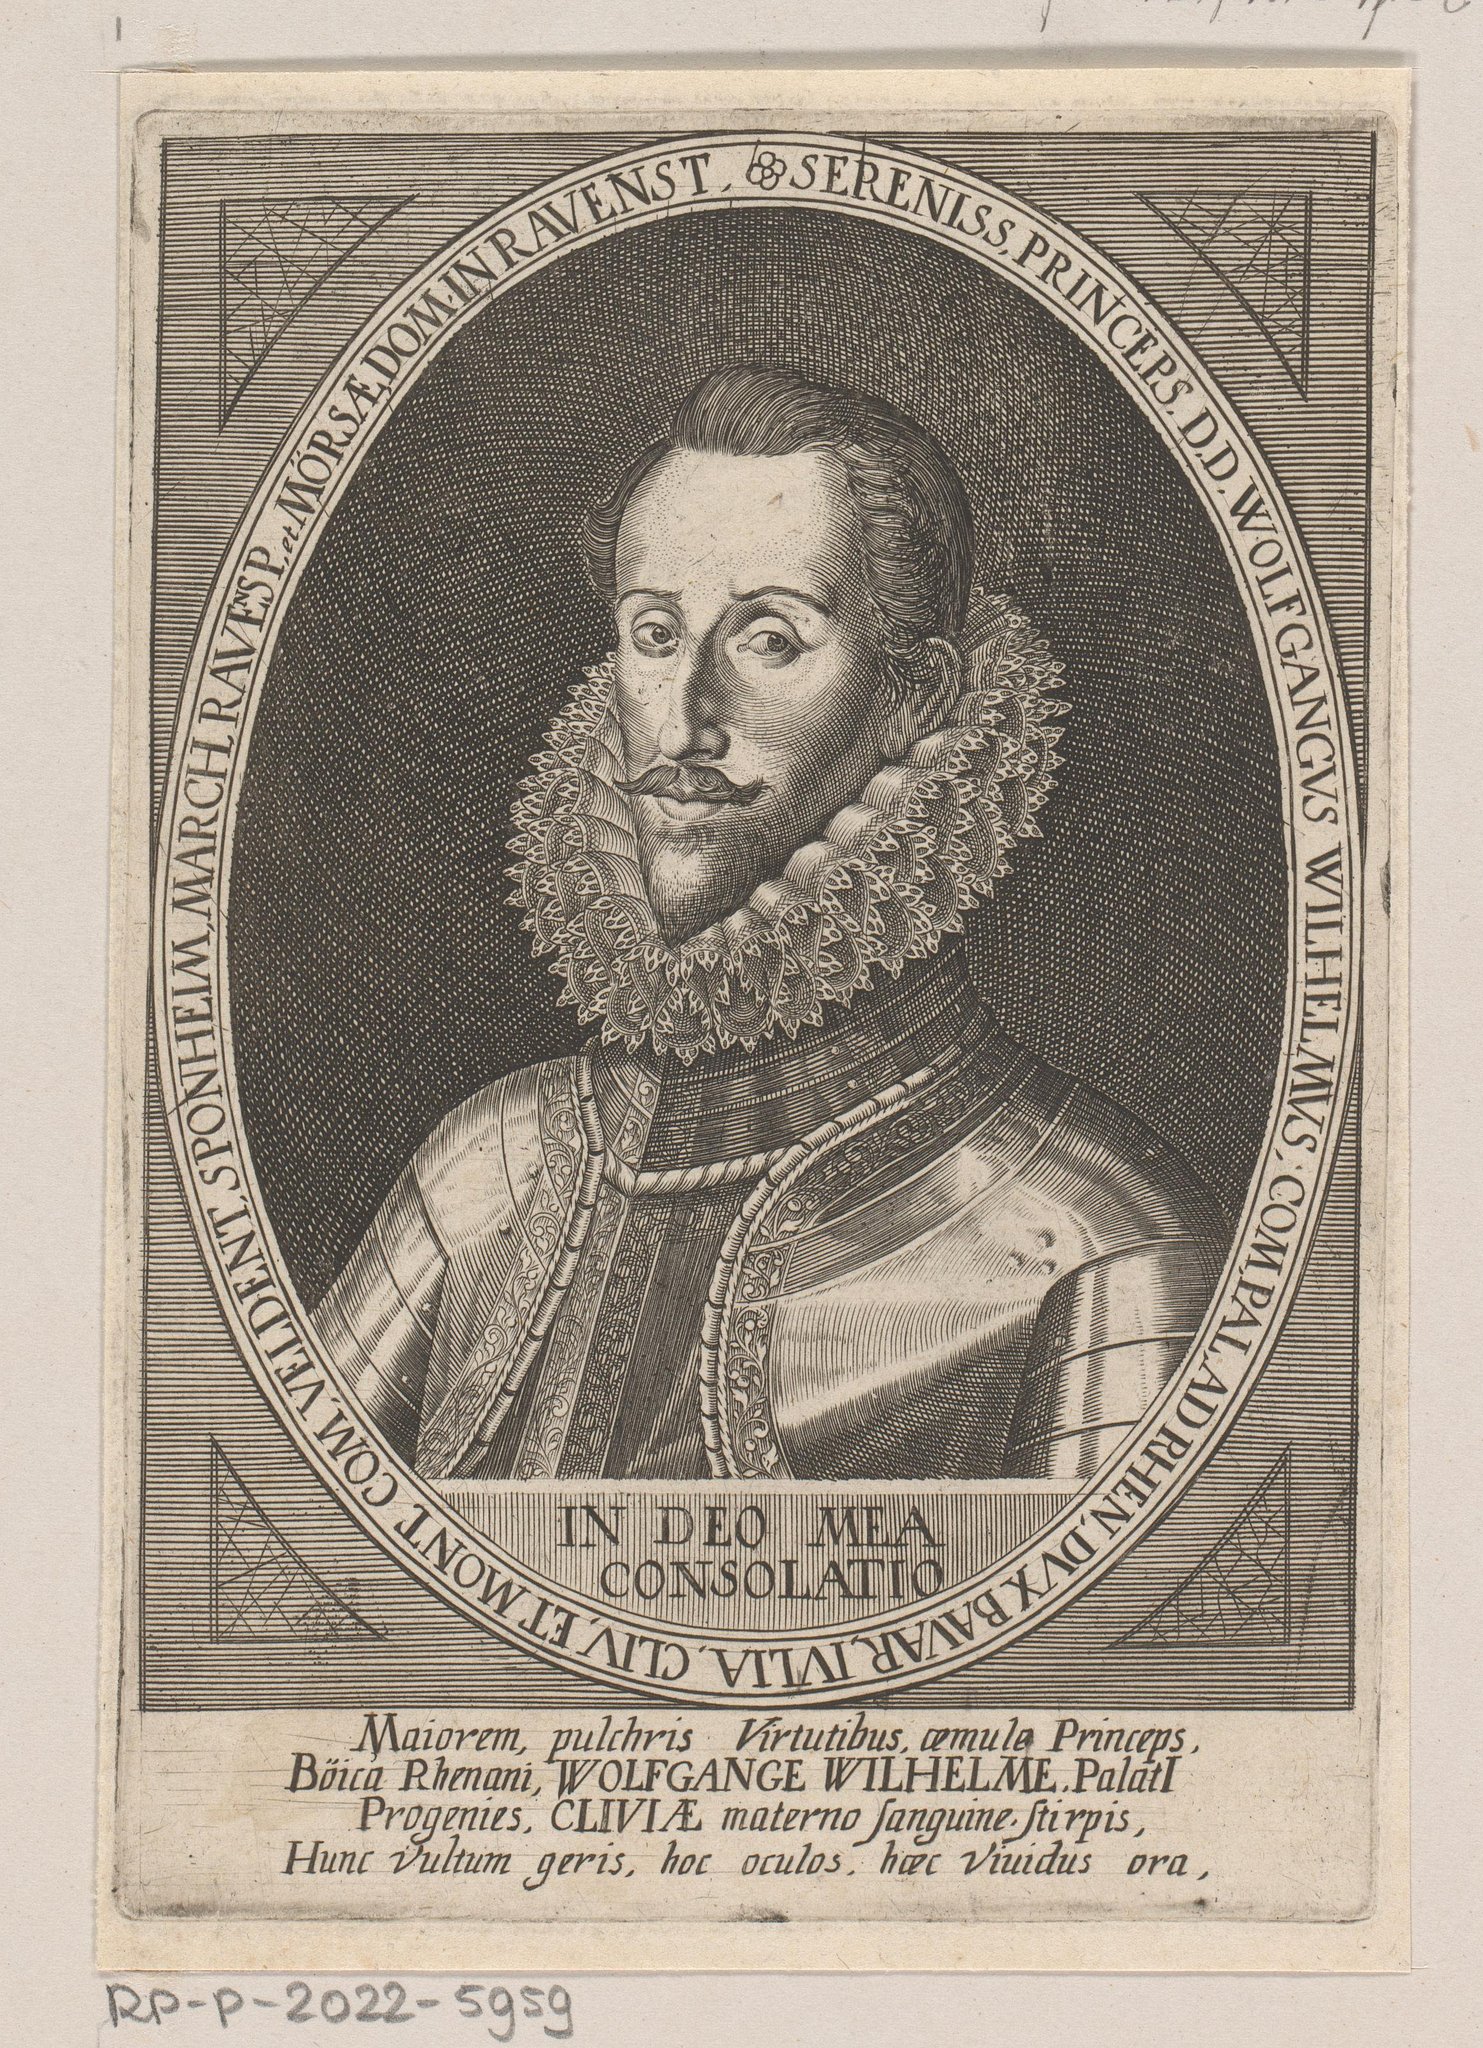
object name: book illustration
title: Portret van Wolfgang Willem van de Palts-Neuburg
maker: Anonymous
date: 1628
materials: paper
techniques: engraving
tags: wolfgang willem van de palts-neuburg, armour, historical persons, ruler, sovereign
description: Prent waarschijnlijk uit: Lundorp, Michael Caspar. Östreichischer Lorberkrantz oder Kayserl. Victori. (...). Frankfurt: Erasmus Kempffern, 1628.